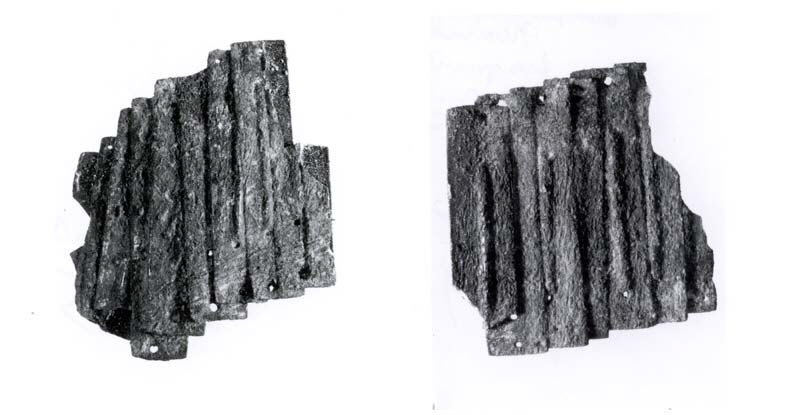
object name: armor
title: Armor plates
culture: assyrian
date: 734-601 BCE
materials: bronze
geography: mesopotamia